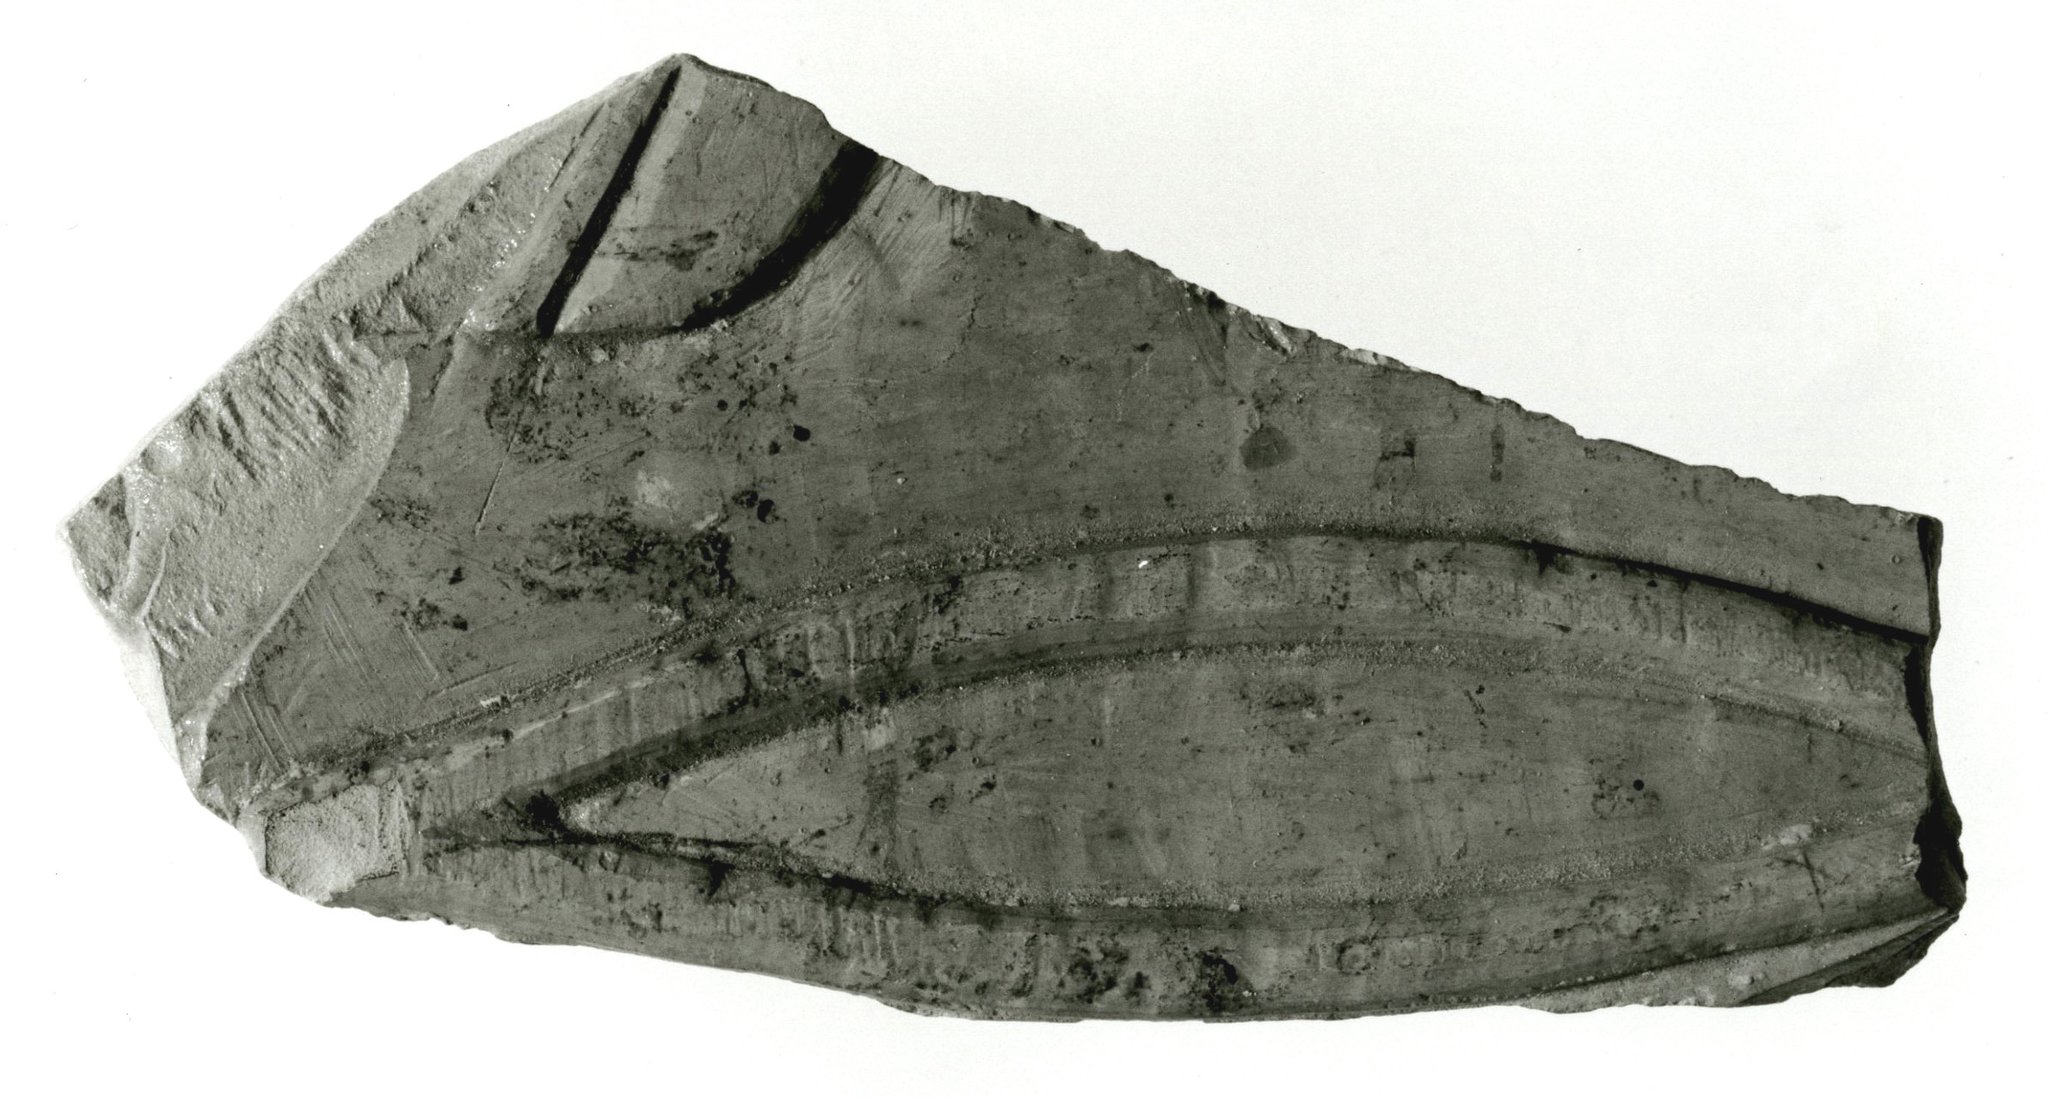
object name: relief, tomb of nespekashuty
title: Raised relief fragment with hieroglyphs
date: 664-610 BCE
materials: limestone, varnish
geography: egypt